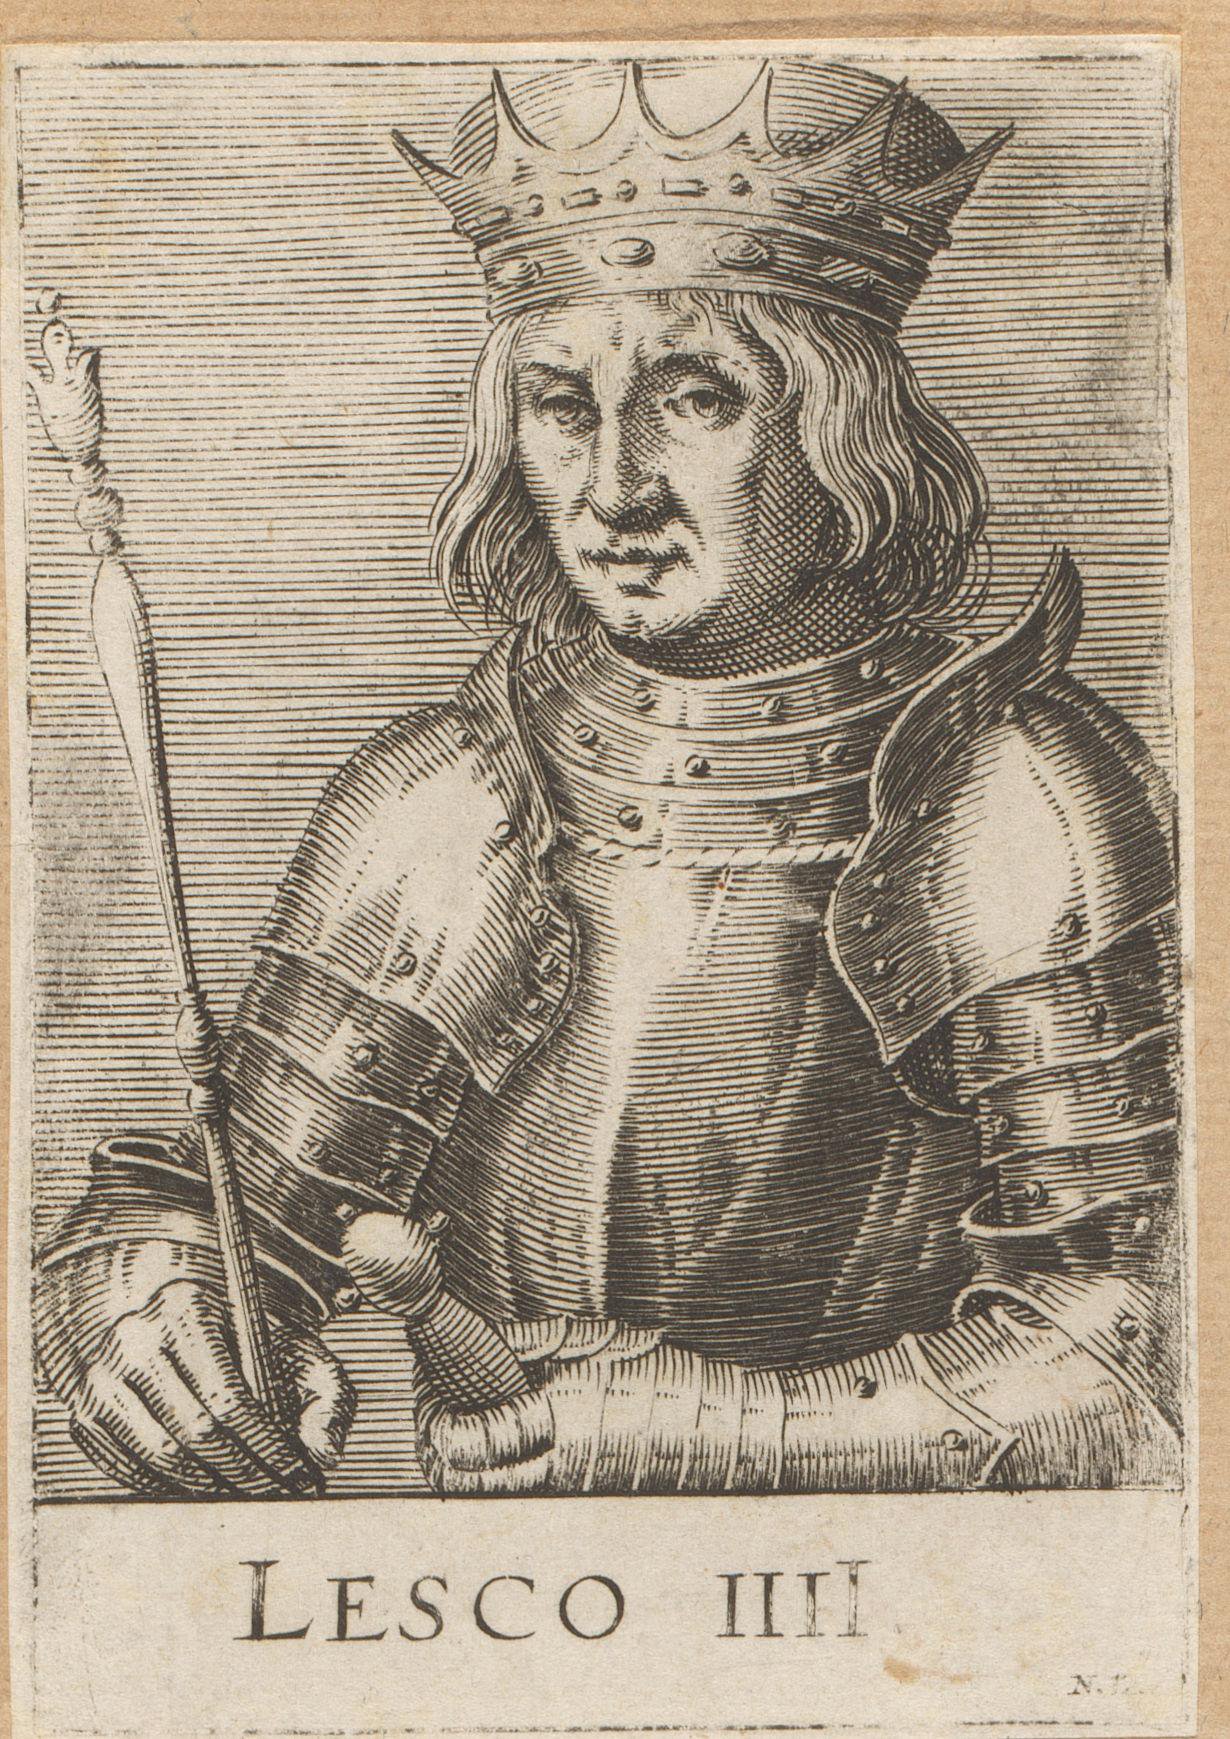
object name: album leaf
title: Portret van Leszko IV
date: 1574-1594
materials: paper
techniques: woodcut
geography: cologne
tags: historical persons, king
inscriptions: collector's mark: Lugt 240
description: Prent gebruikt in: Mylius, Arnold. Principum et Regum Polonorum Imagines ad Vivum Expressae (...). Keulen: Gottfried von Kempen, 1594.